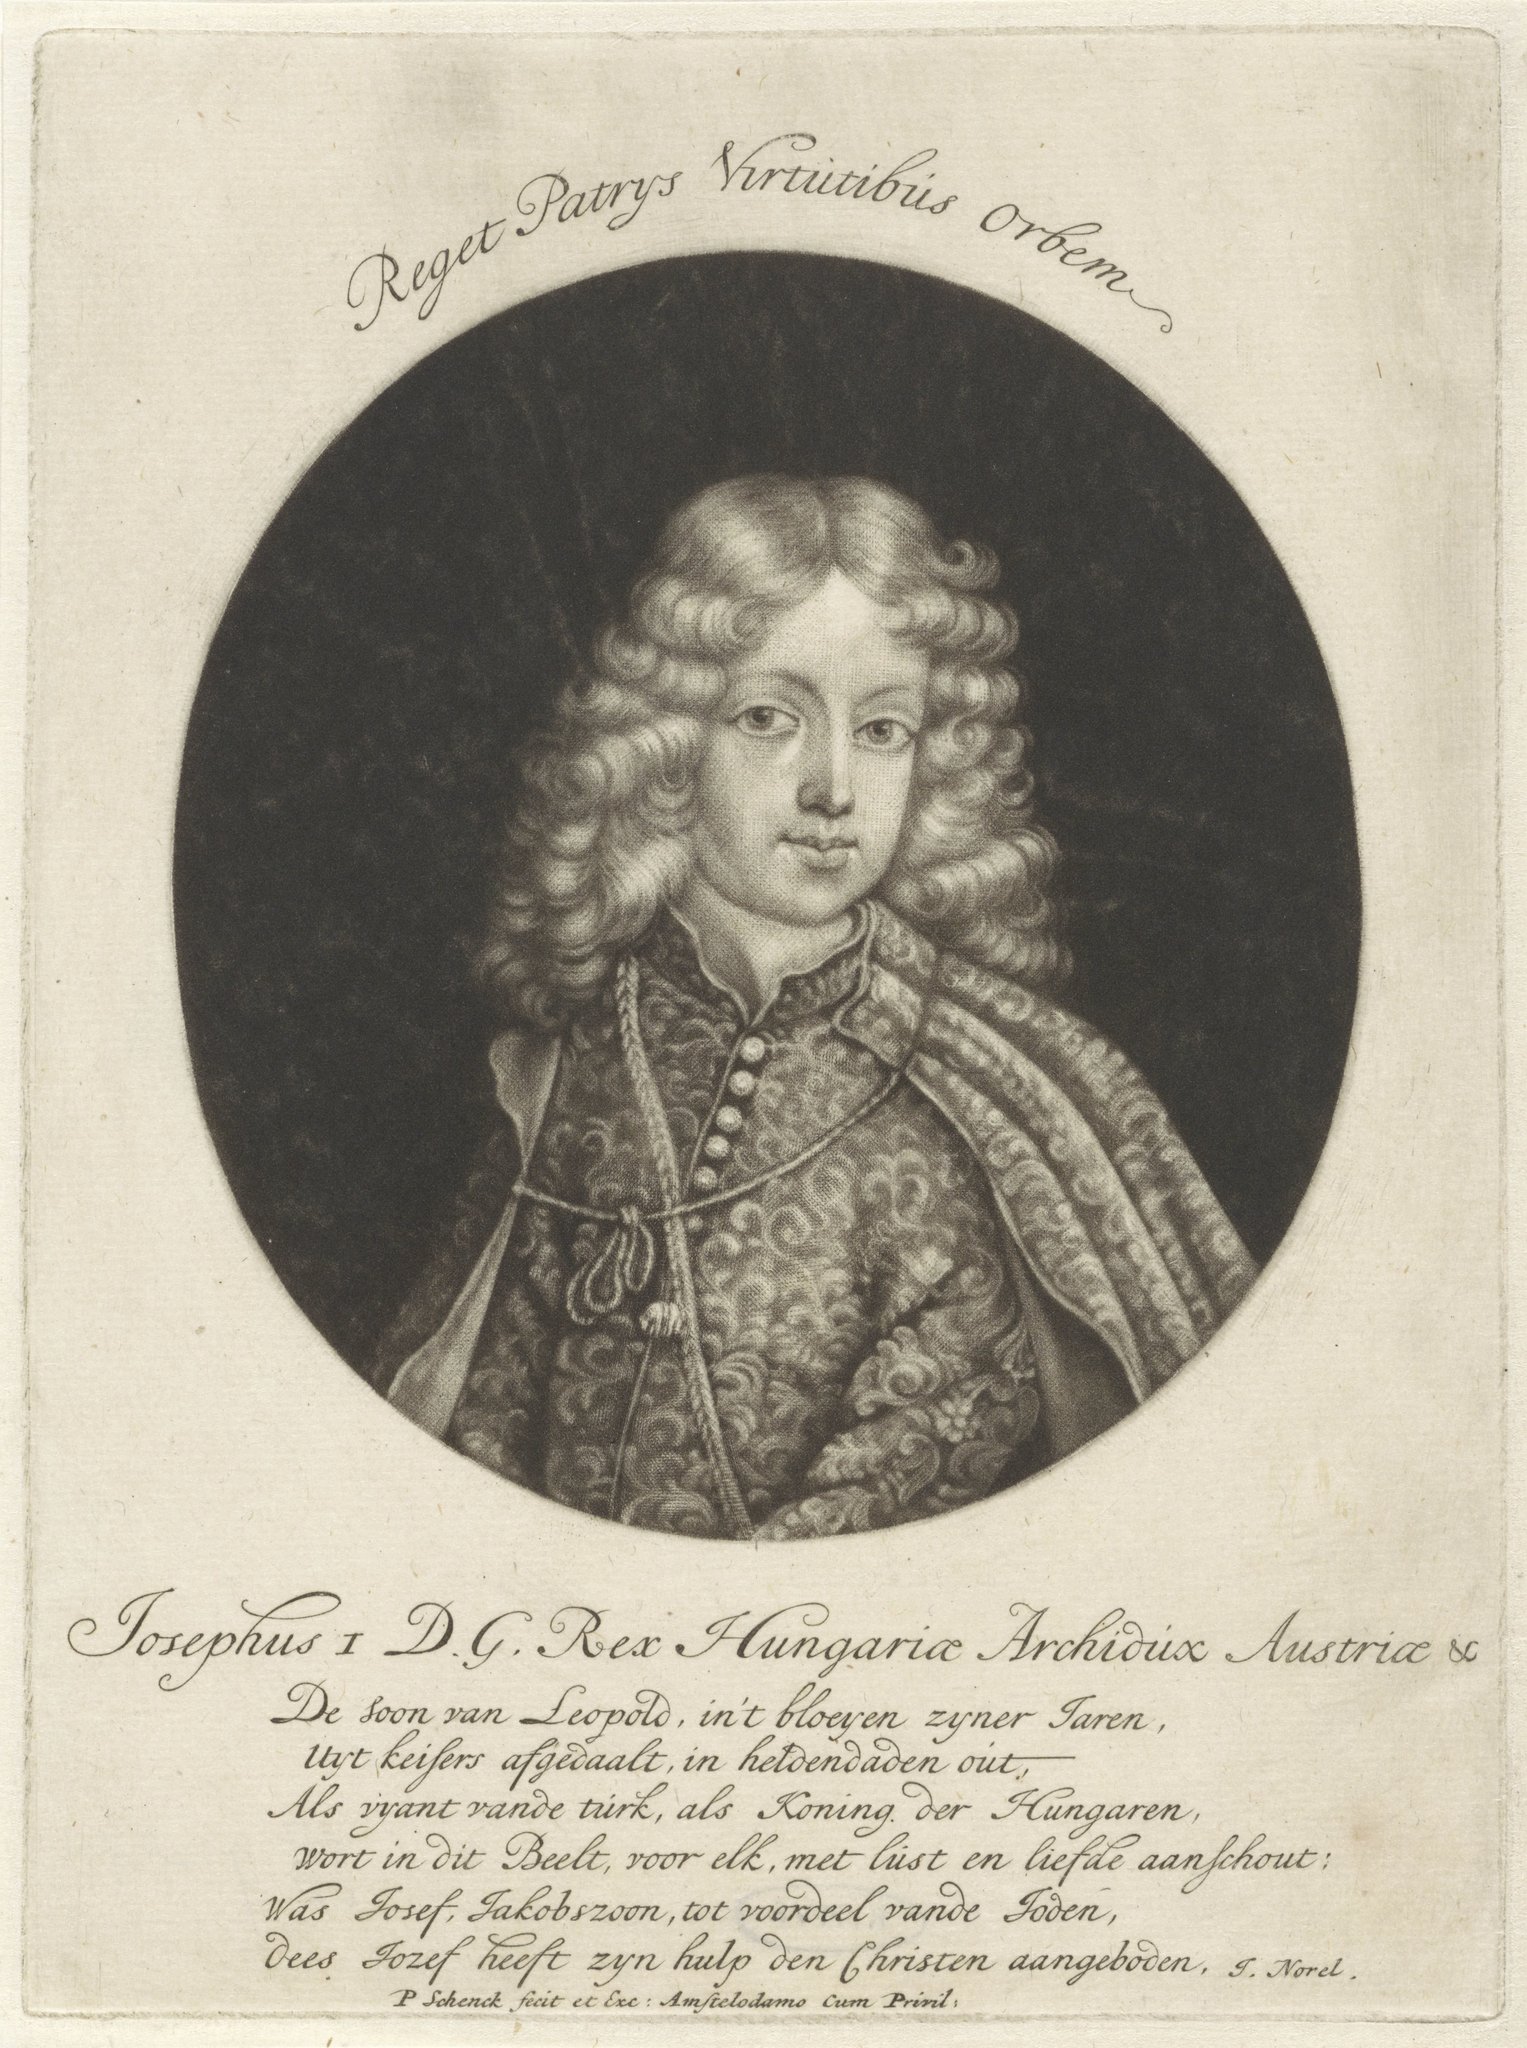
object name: print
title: Portret van keizer Jozef I op jonge leeftijd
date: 1685-1713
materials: paper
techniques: engraving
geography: amsterdam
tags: vienna, jozef i (duits keizer), knighthood order of the golden fleece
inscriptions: collector's mark: Lugt 2228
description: Portret van Jozef I, keizer van het Heilig Roomse Rijk en koning van Hongarije. Om zijn hals een keten met het teken van de Orde van het Gulden Vlies.